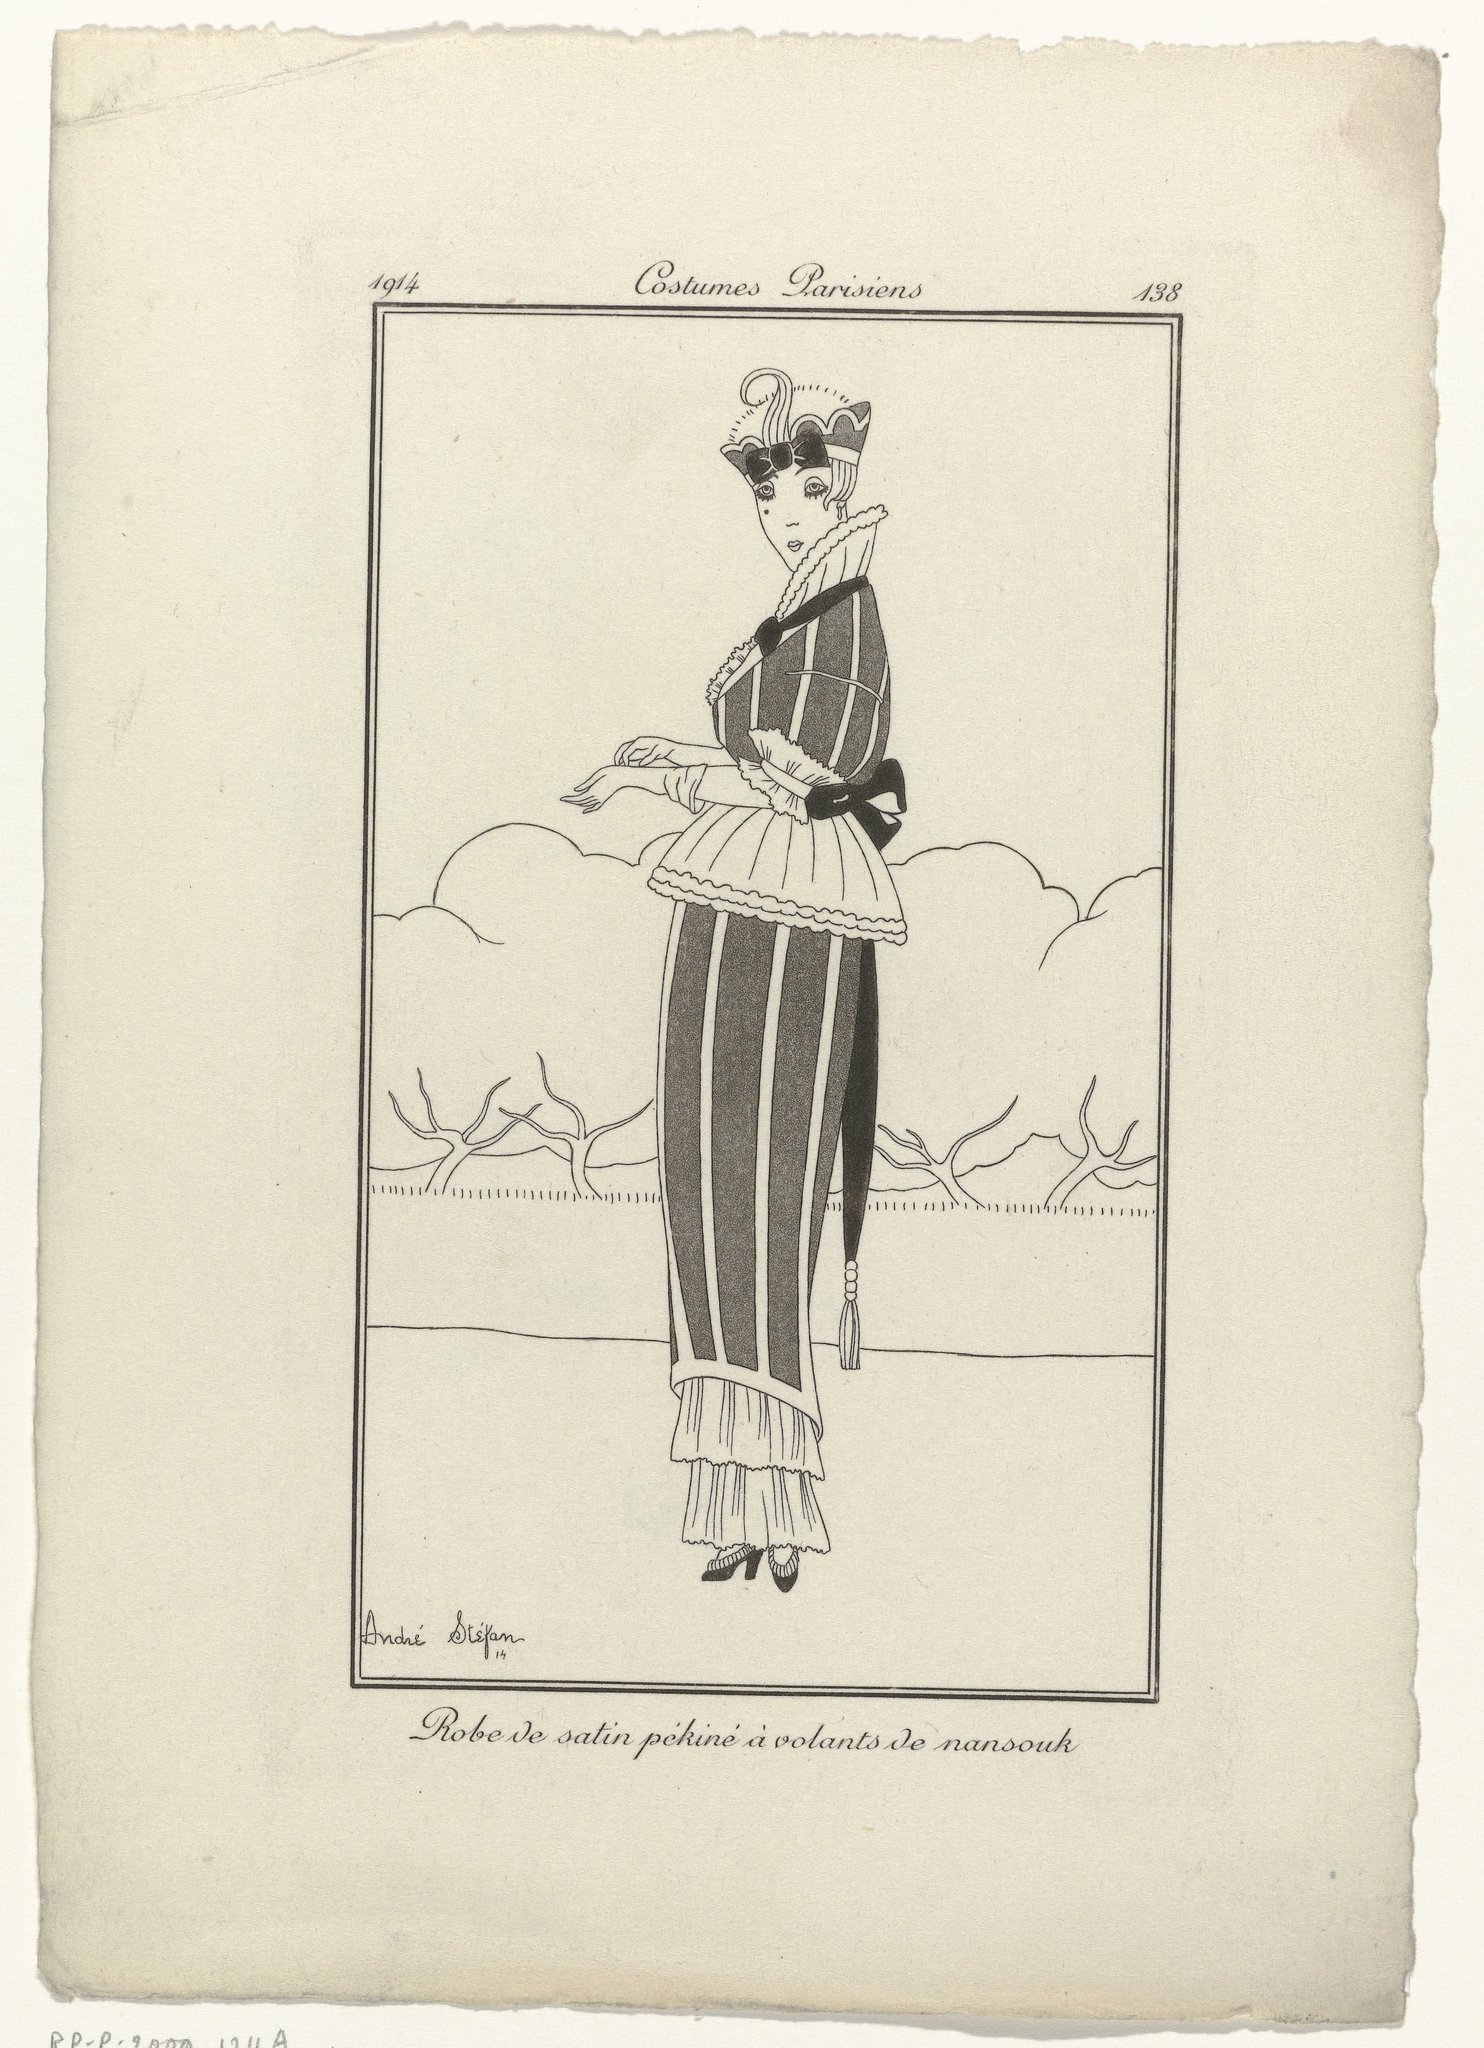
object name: fashion print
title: Journal des Dames et des Modes, Costumes Parisiens, 1914, No. 138 : Robe de satin (...)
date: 1914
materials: paper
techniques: engraving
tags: ornamental parts of clothing (+ women's clothes), head-gear (+ women's clothes), fashion plates, gloves, mittens, etc. (+ women's clothes), dress, gown (+ women's clothes)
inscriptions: caption: ‘Robe de satin pékiné à volants de nansouk’, title: ‘Costumes Parisiens’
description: Japon van satijn 'pékiné' (pekin) met gerimpelde stroken stof van nansoek. Proefdruk van een prent uit het modetijdschrift Journal des Dames et des Modes (1912-1914).